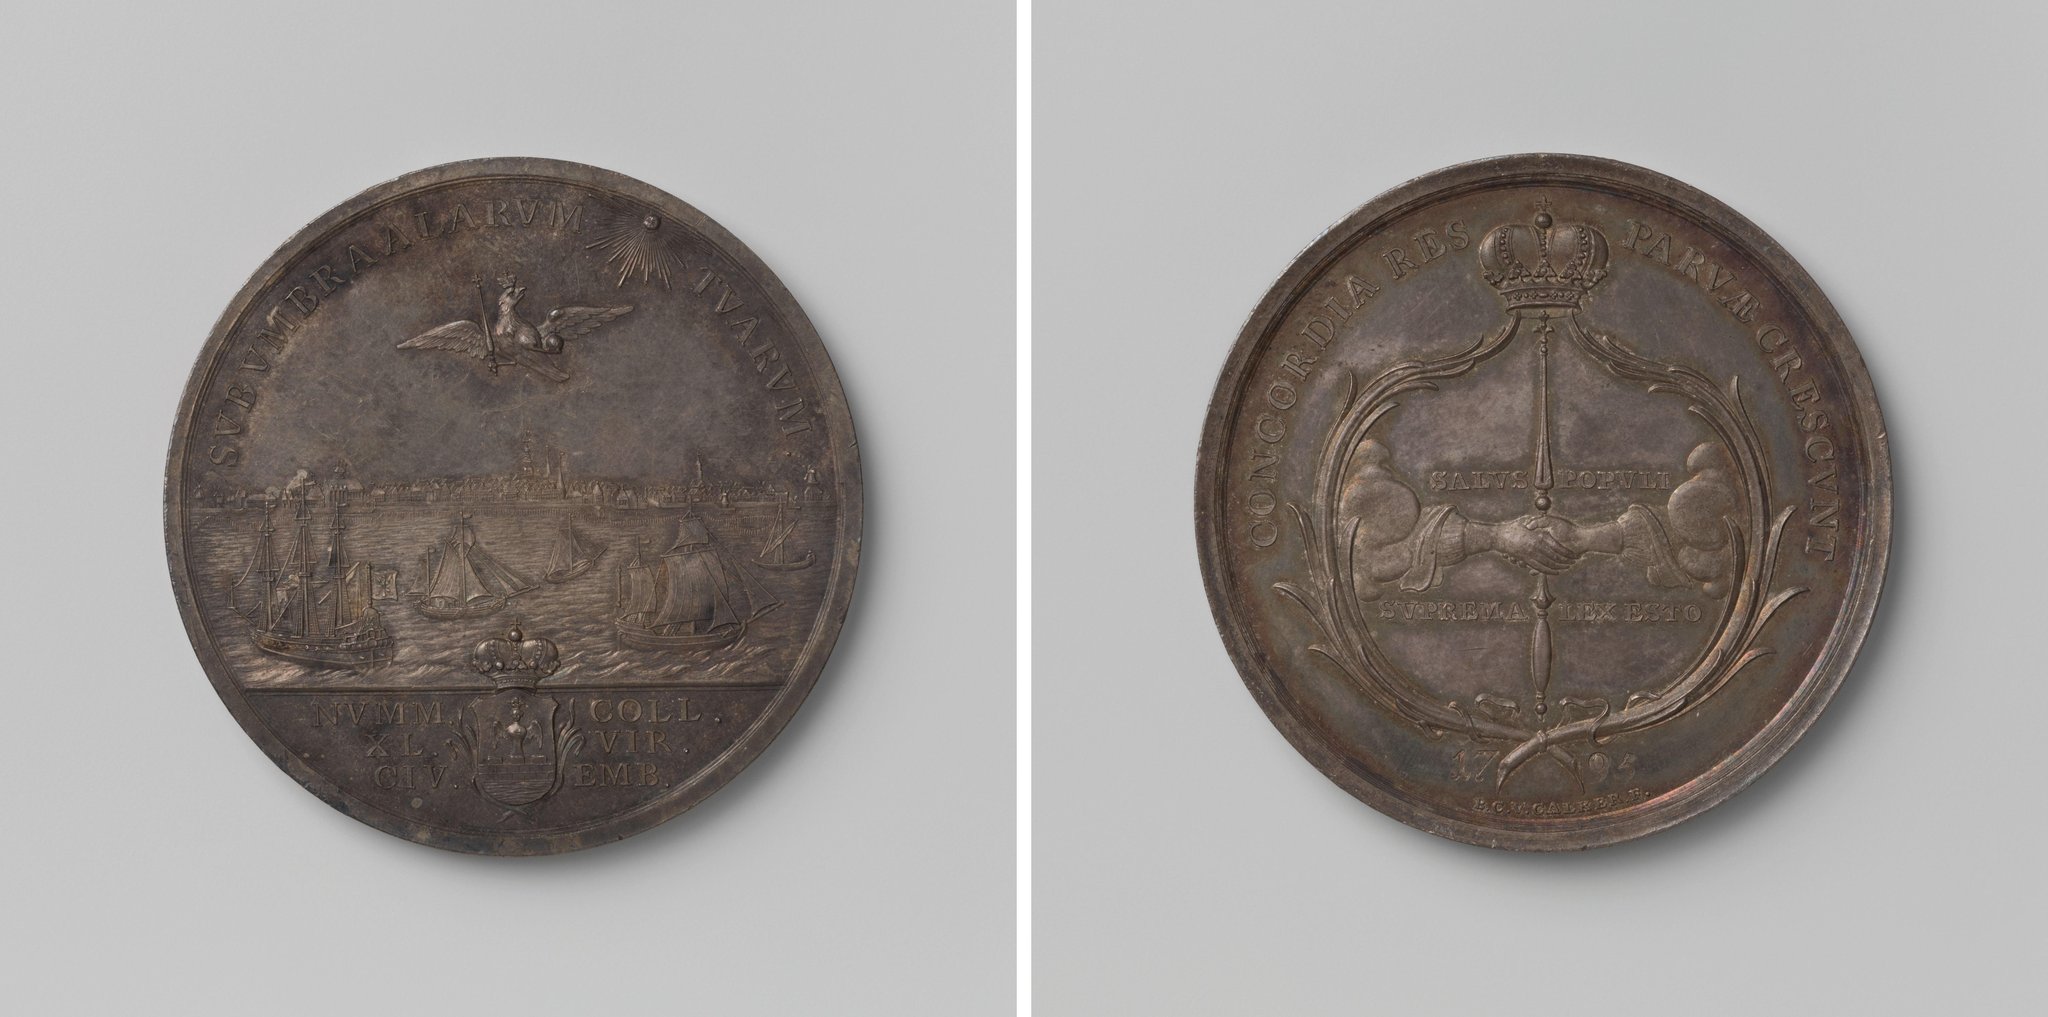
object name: council medal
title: Vroedschapspenning van de stad Embden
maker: barend christiaan van calker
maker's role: medailleur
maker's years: 1739-1813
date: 1795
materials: silver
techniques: engraving, striking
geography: zeist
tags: emden